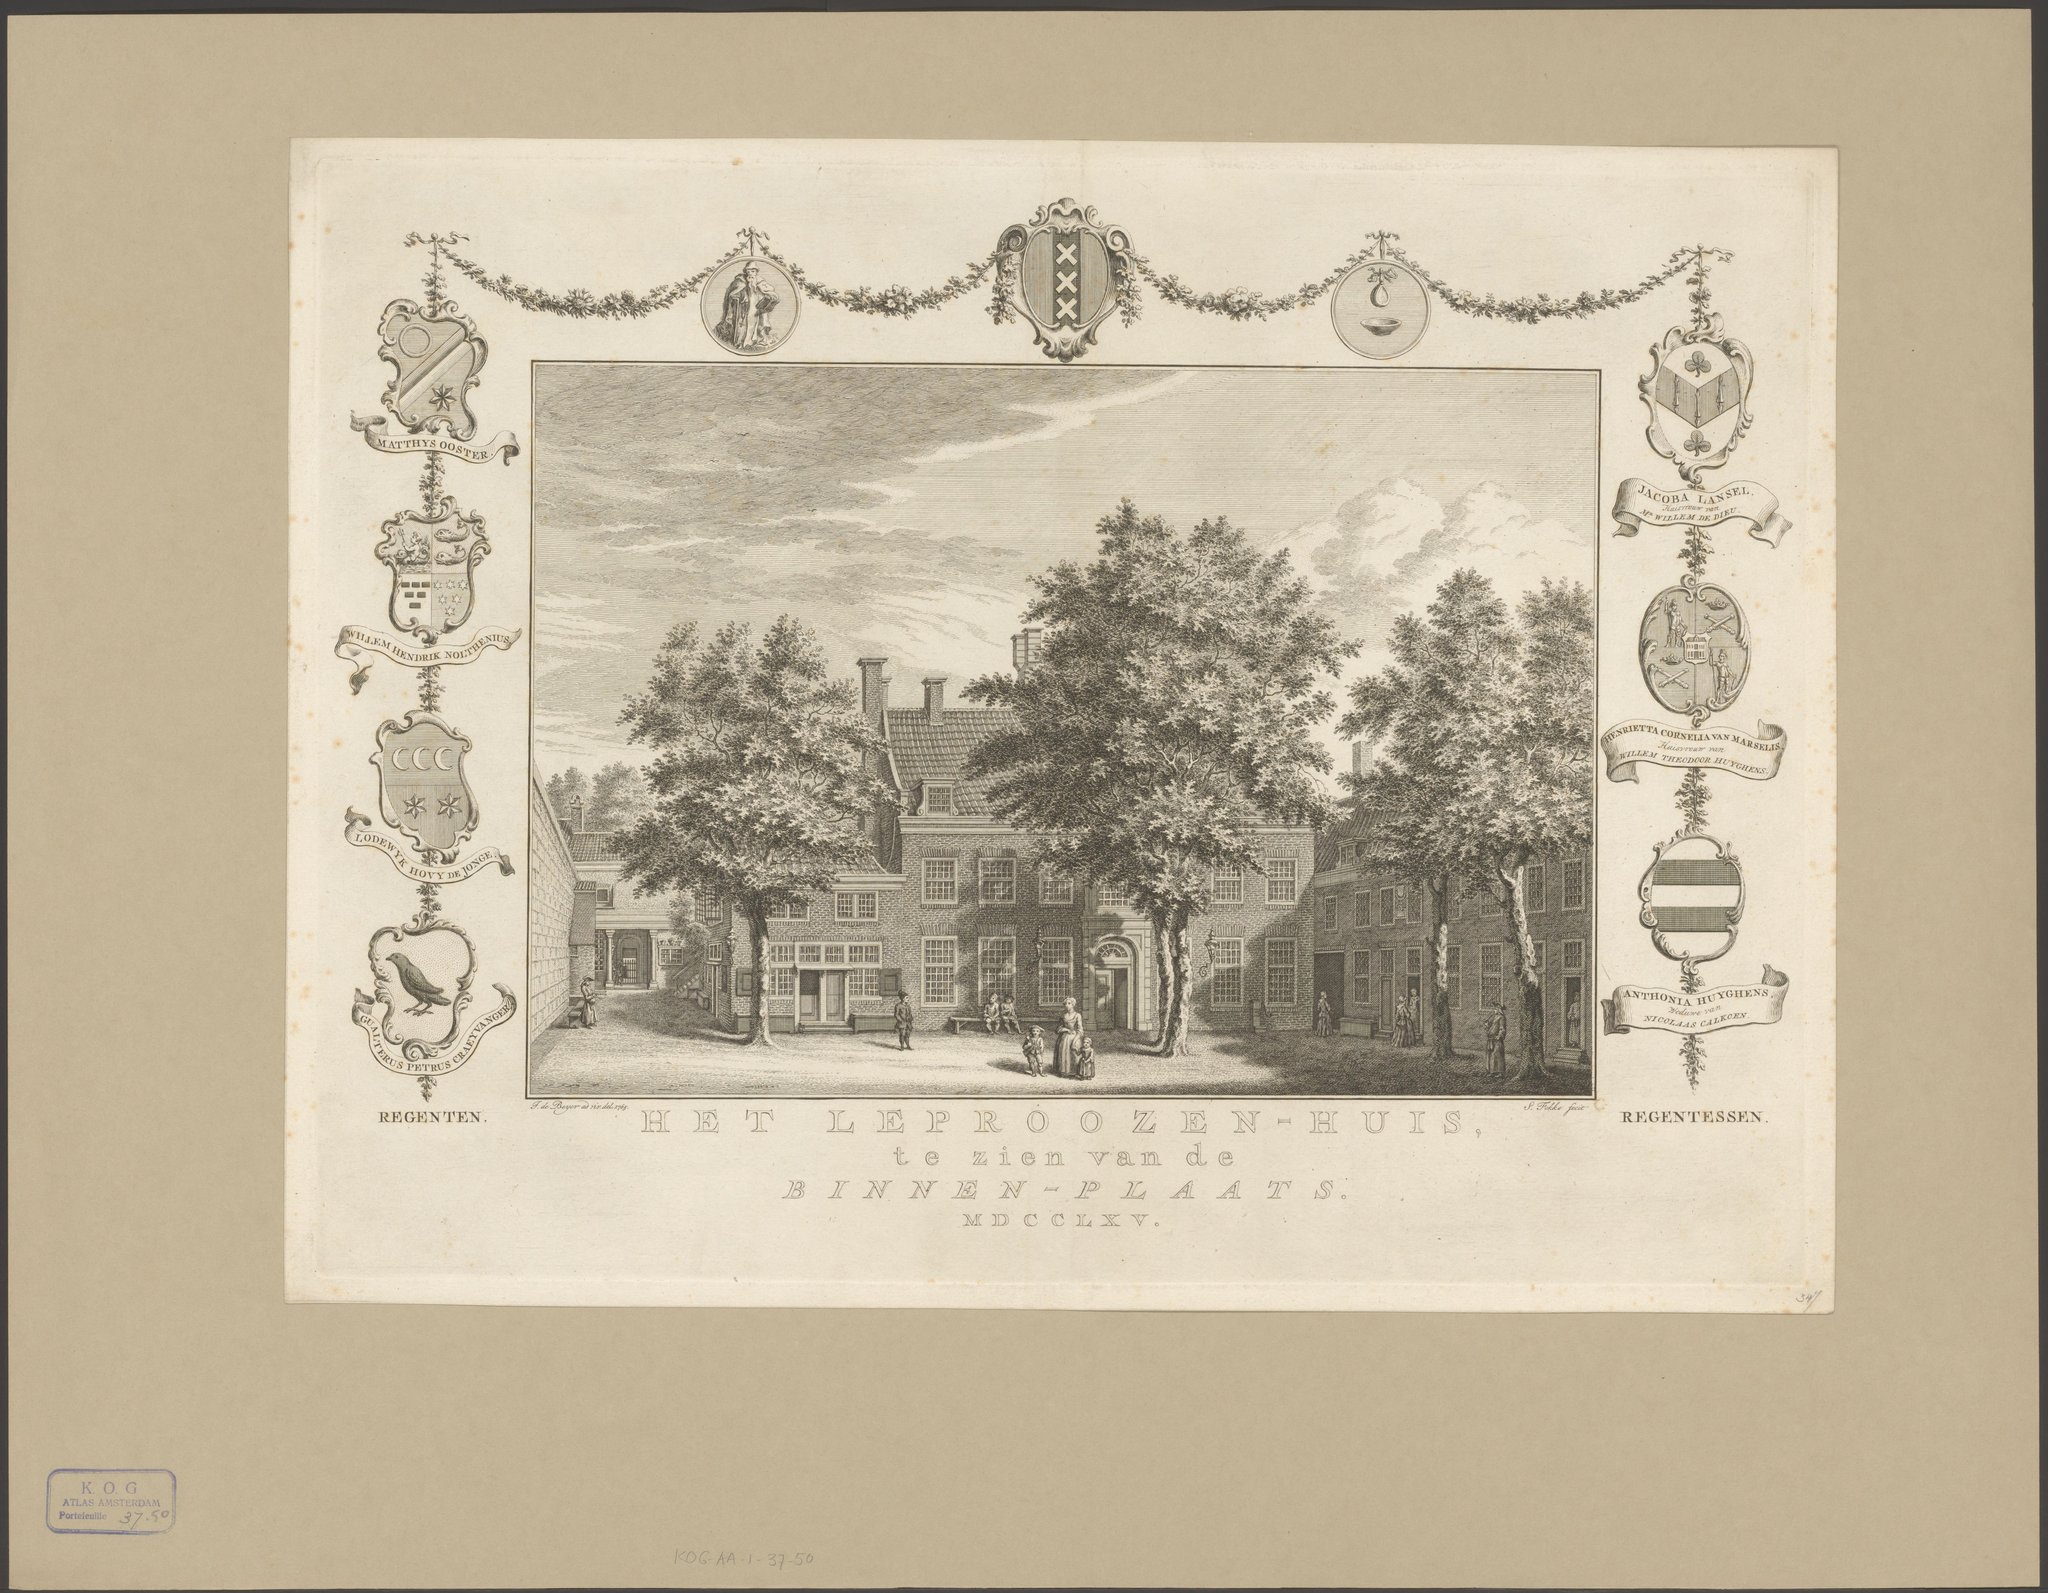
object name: print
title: Het Leproozen-Huis, te zien van de binnen-plaats. MDCCLXV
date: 1765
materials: paper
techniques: engraving, etching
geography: amsterdam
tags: coat of arms (as symbol of the state, etc.) (+ city; municipal), leprosarium, ornament ~ medallion, hospital, courtyard, armorial bearing, heraldry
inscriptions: collector's mark: Lugt 1641b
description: Gezicht op de binnenplaats van het Leprozenhuis te Amsterdam, gelegen aan de Lazarussteeg tegenover de Portugese Synagoge, 1765. Rond de voorstelling een guirlande, met aan de zijkanten de wapens van de regenten en regentessen uit het jaar 1765 en bovenaan een medaillon met Sint-Antonius, het wapen van Amsterdam en een medaillon met een leprozenklepper en een bedelnap. Onderwerpsrubriek binnen de Atlas Amsterdam: Armwezen en liefdadige instellingen: I. Stadsinrichtingen: Leprozen- of Lazarushuis, omgang van leprozen, regenten.